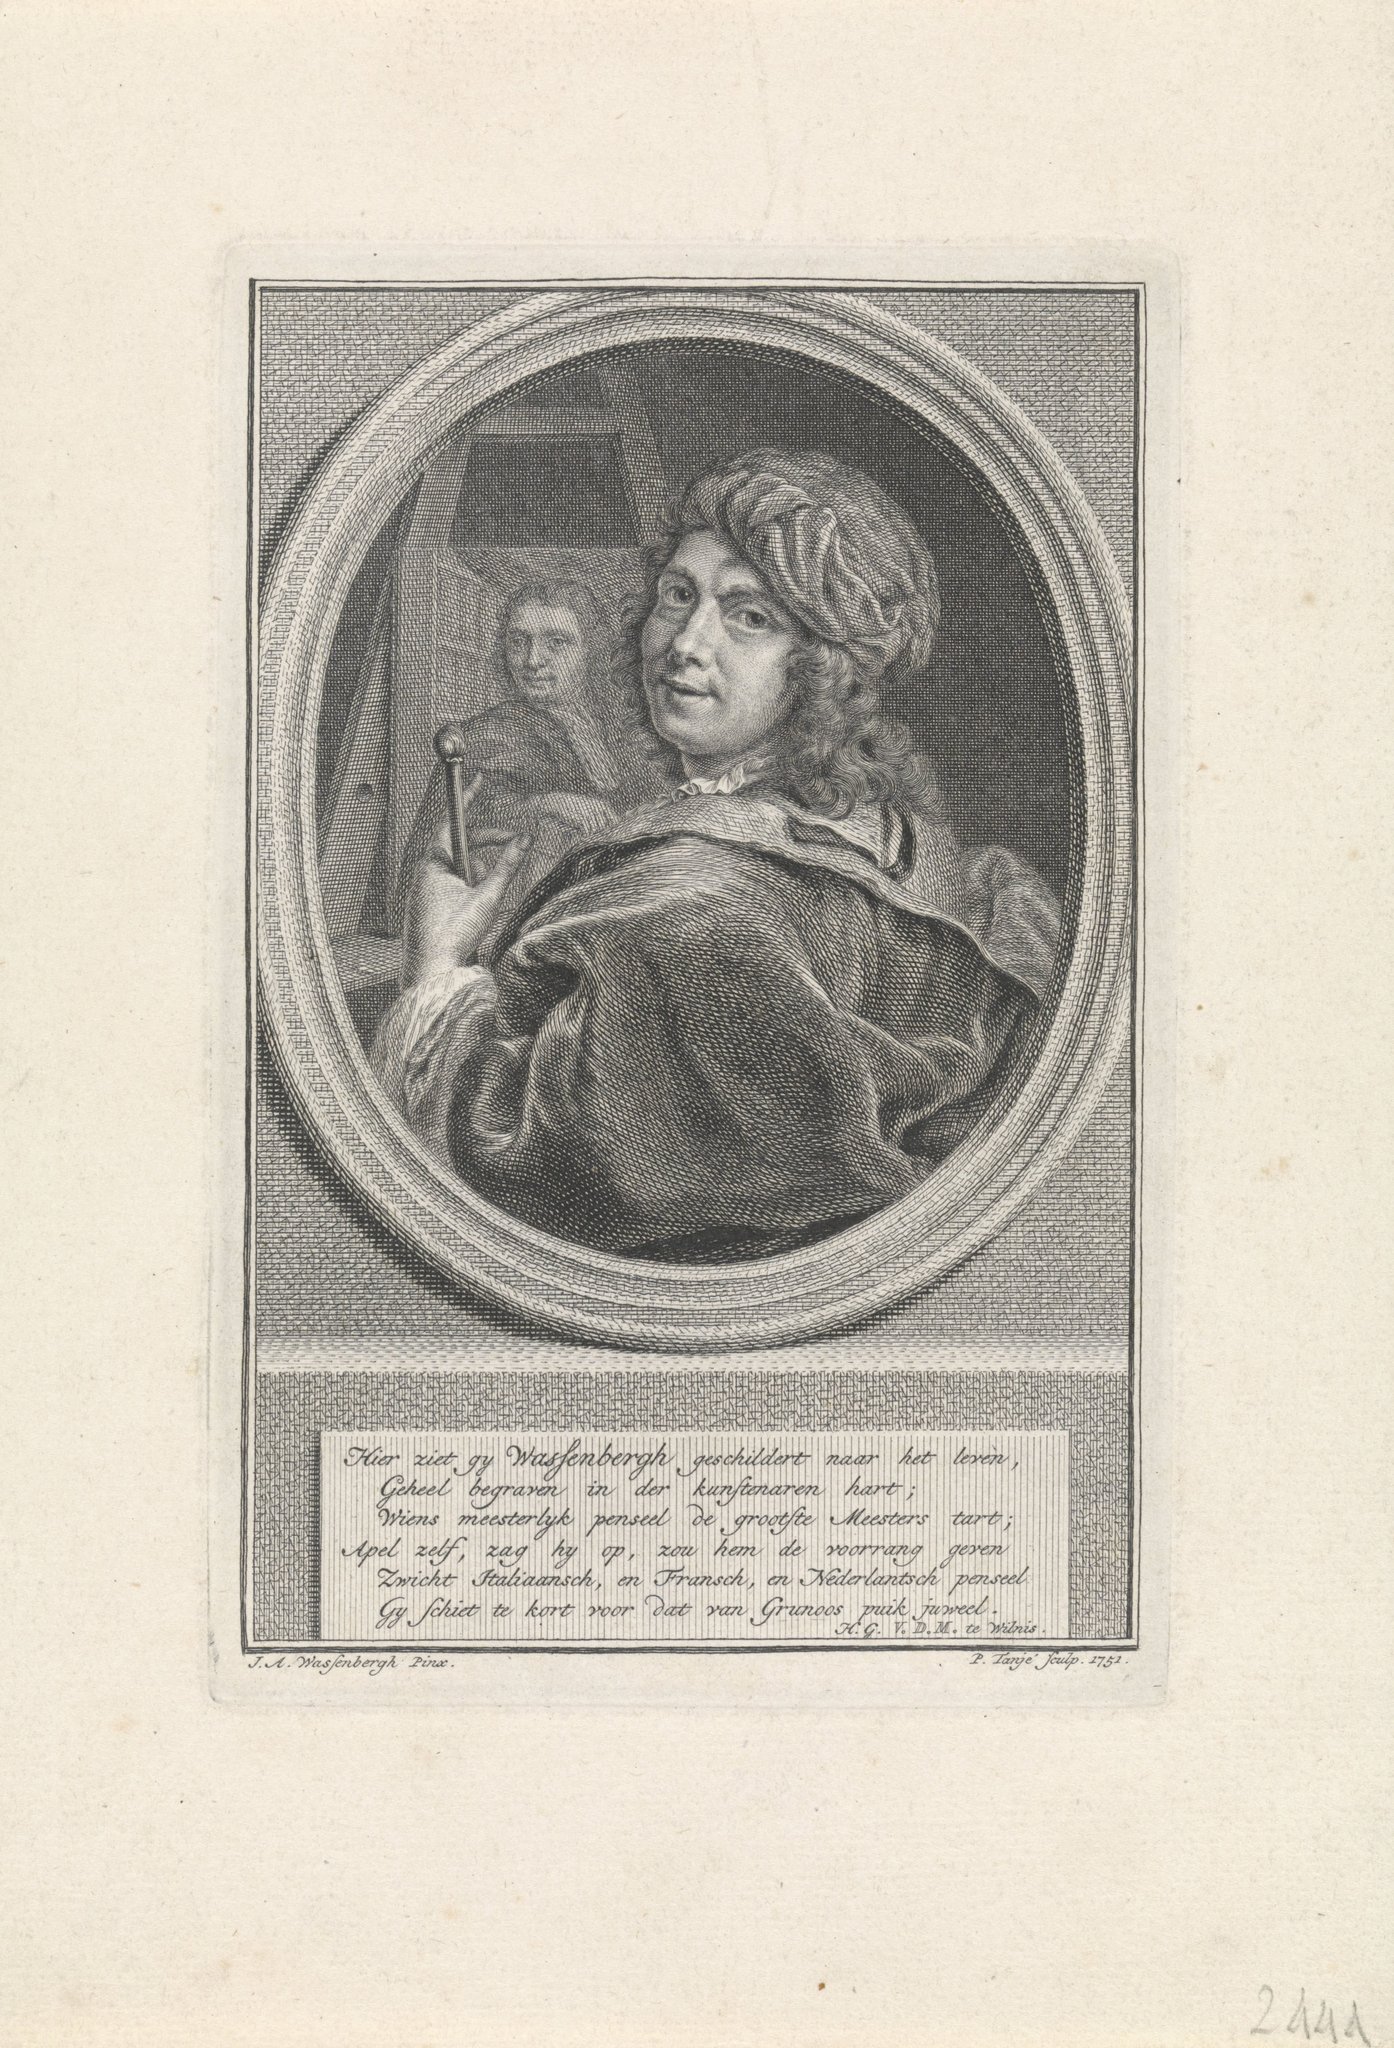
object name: print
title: Portret van Jan Abel Wassenbergh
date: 1751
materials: paper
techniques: engraving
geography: amsterdam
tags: jan abel wassenbergh, portrait, self-portrait of painter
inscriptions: collector's mark: Lugt 2228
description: Portret van de schilder Jan Abel Wassenbergh, over zijn schouder kijkend, staand bij een door hem geschilderd portret. In zijn hand houdt hij een schilderstok.